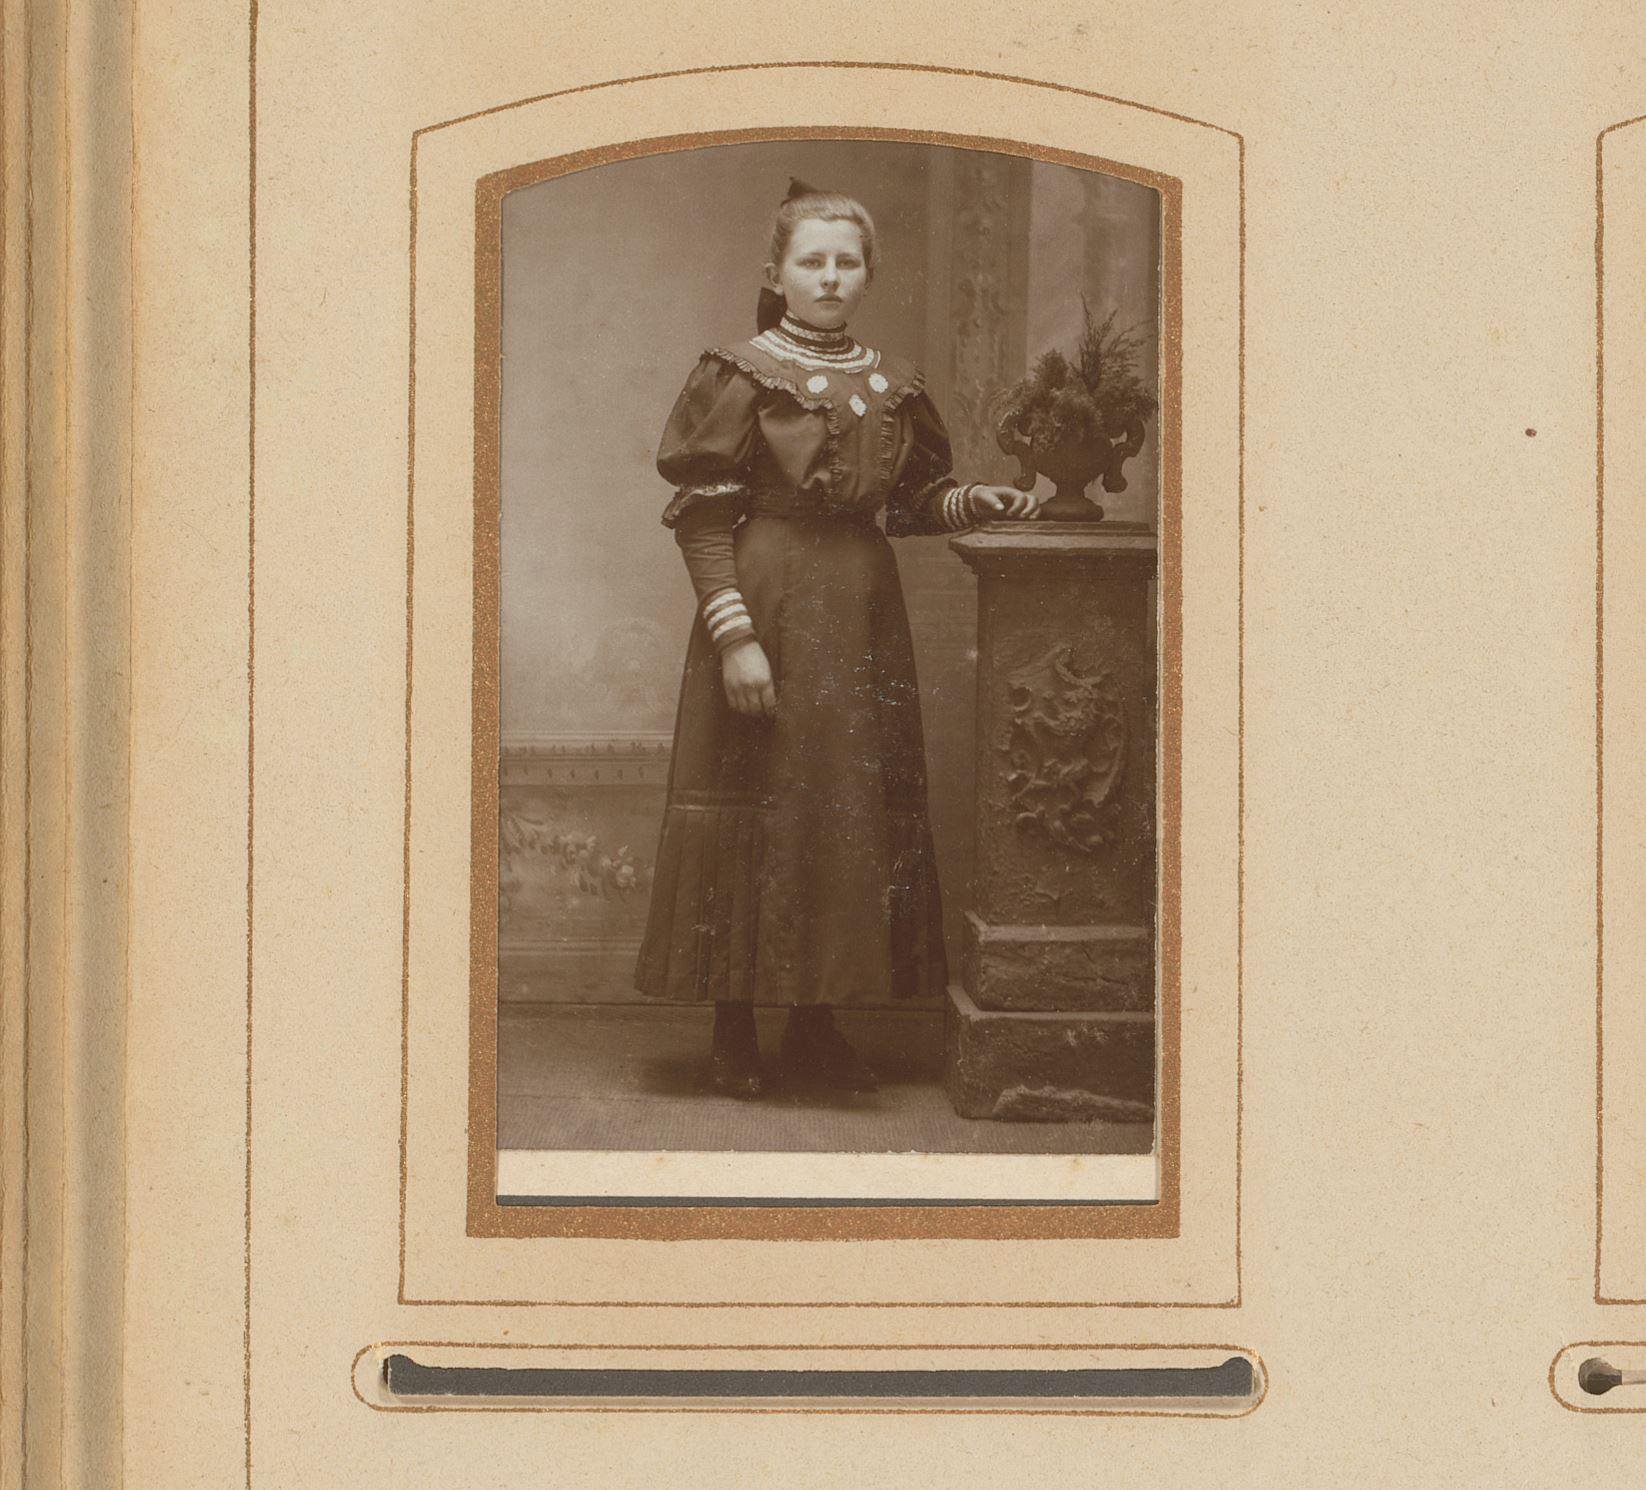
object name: album leaf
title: Portret van een staand meisje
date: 1895-1904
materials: cardboard, photographic support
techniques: collodion silver print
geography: haarlem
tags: girl (child between toddler and youth)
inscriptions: inscription: ‘Atelier Studio/ Haarlem/ Zoetestraat hoek Zylstraat’